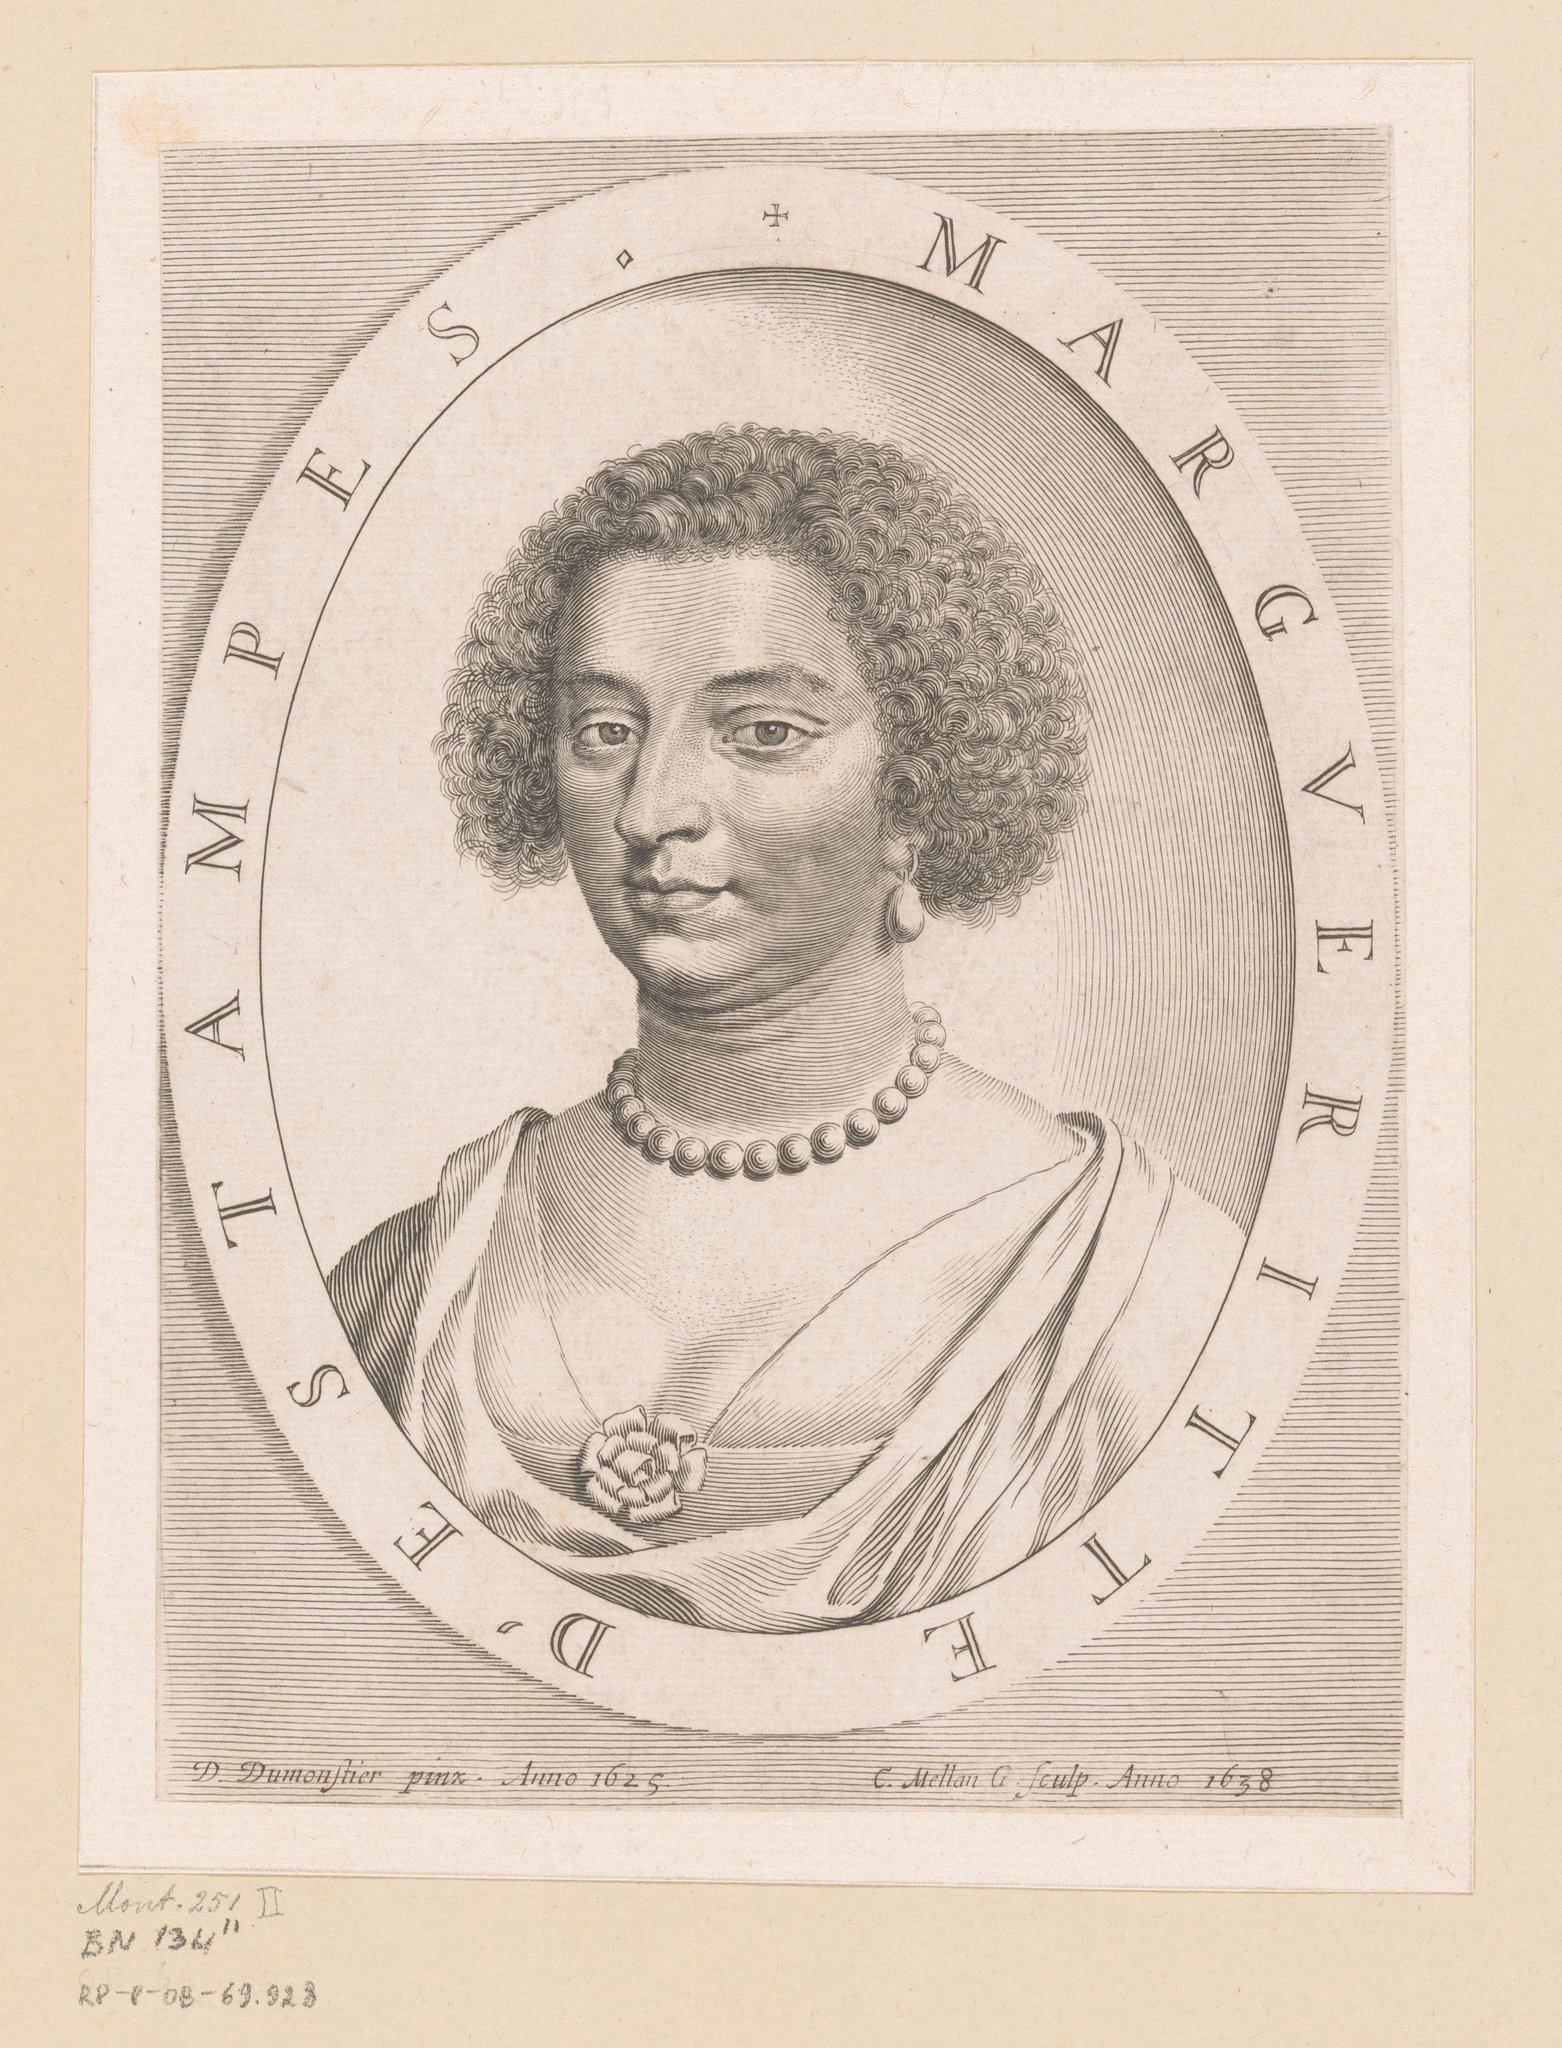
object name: print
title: Portret van Marguerite d'Étampes, barones van Archères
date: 1638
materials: paper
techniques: engraving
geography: france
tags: historical persons - bb - woman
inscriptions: collector's mark: Lugt 240